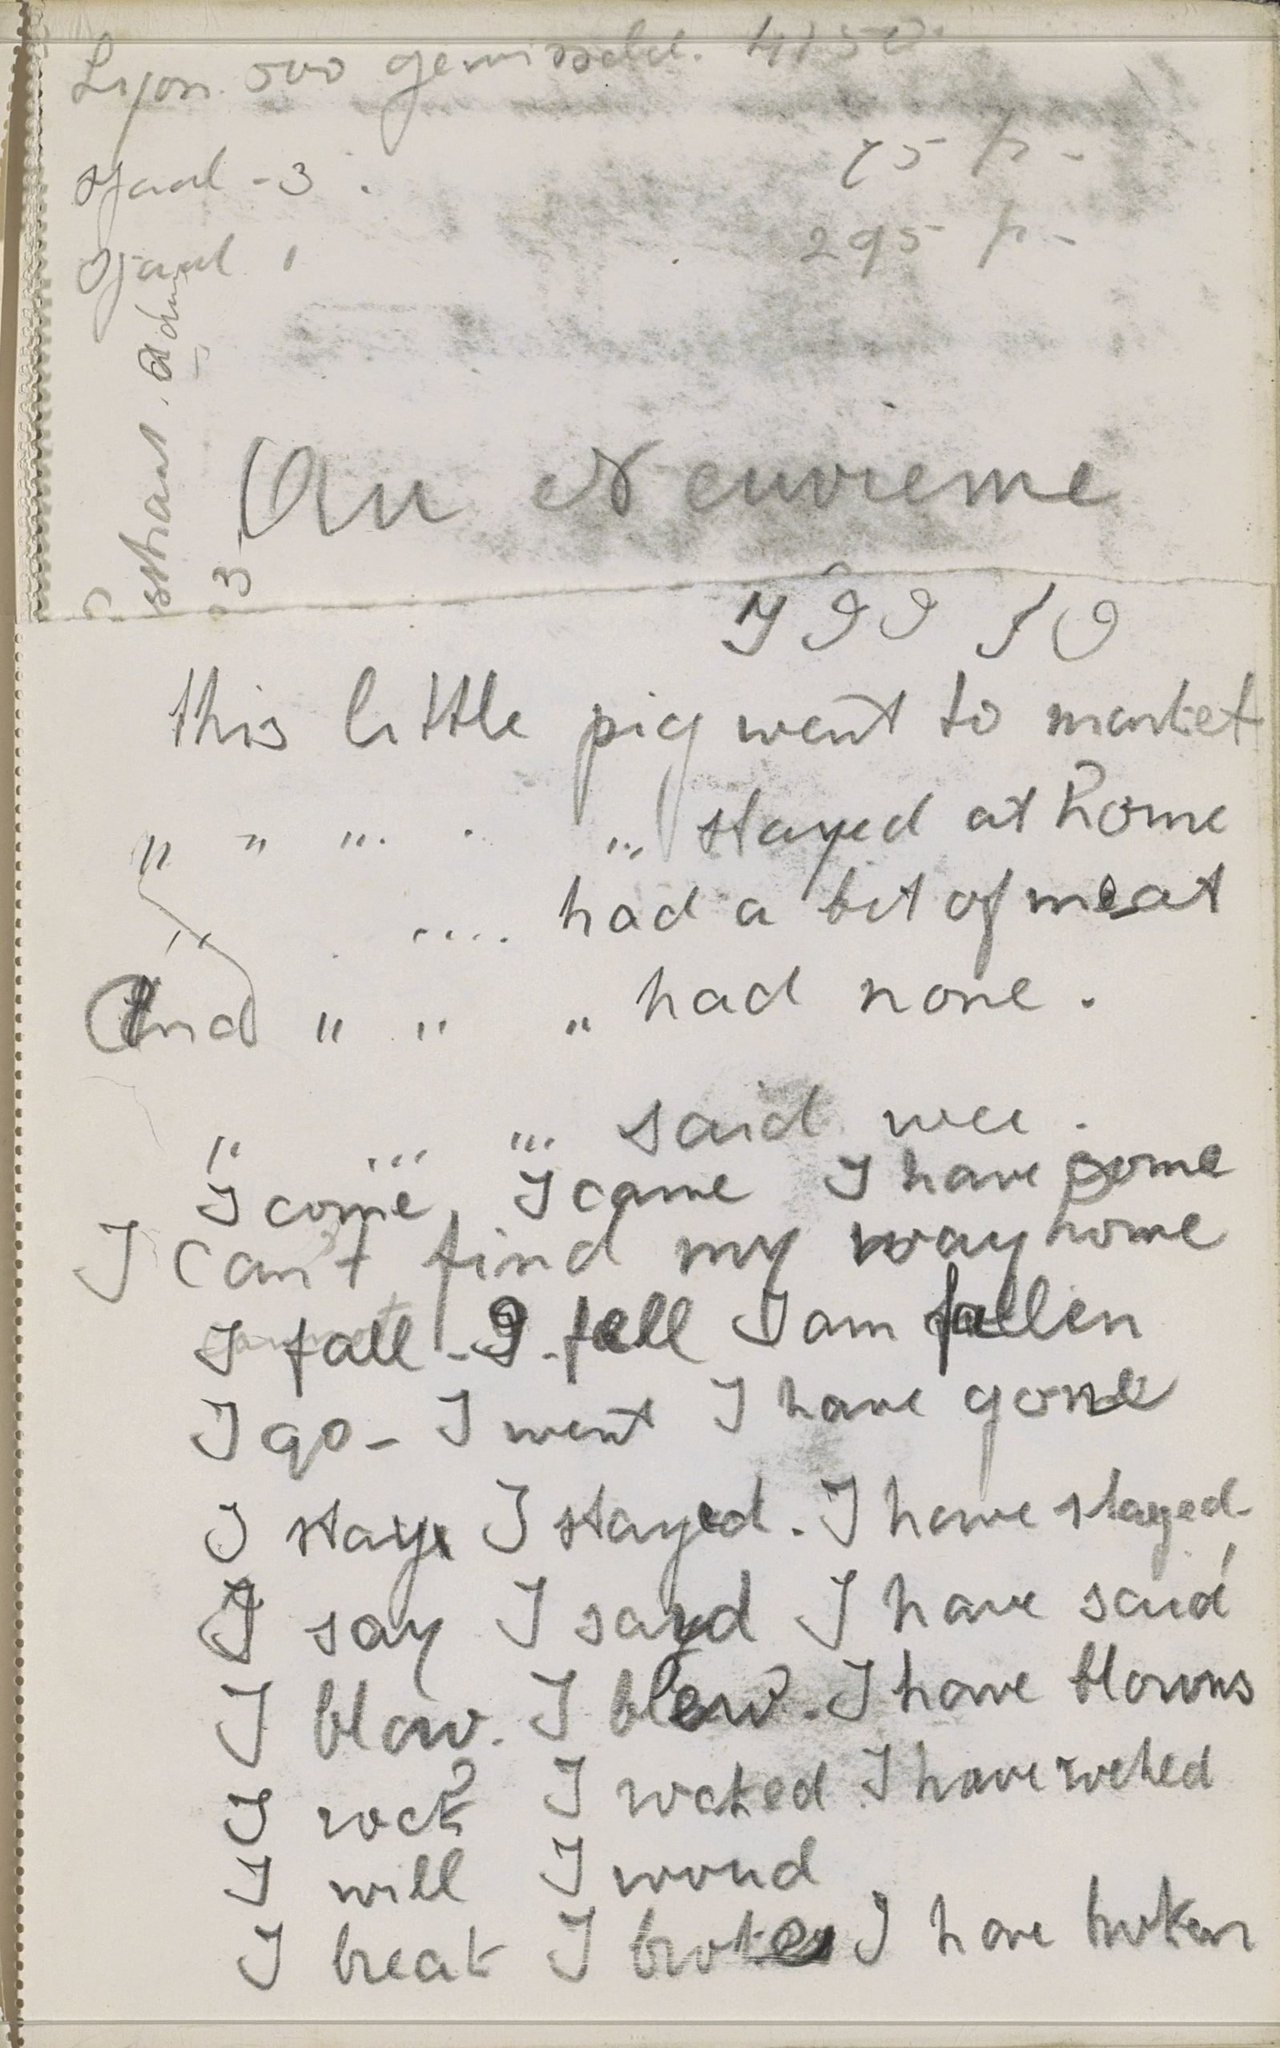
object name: sketchbook leaf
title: Tekst van het Engelse kinderliedje 'This Little Pig'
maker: cornelis vreedenburgh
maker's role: draughtsman, print maker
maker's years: 1880-1946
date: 1890-1946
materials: paper, pencil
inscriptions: annotation: ‘[...]/ this little pig went to market/ [...]’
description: Blad 52 recto uit een schetsboek met 53 bladen.